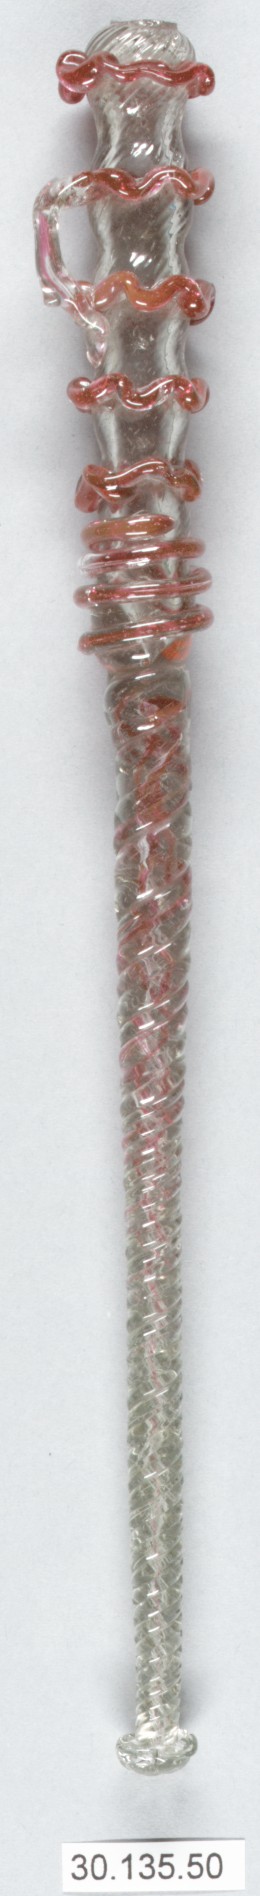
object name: bobbin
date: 1701-1800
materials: glass